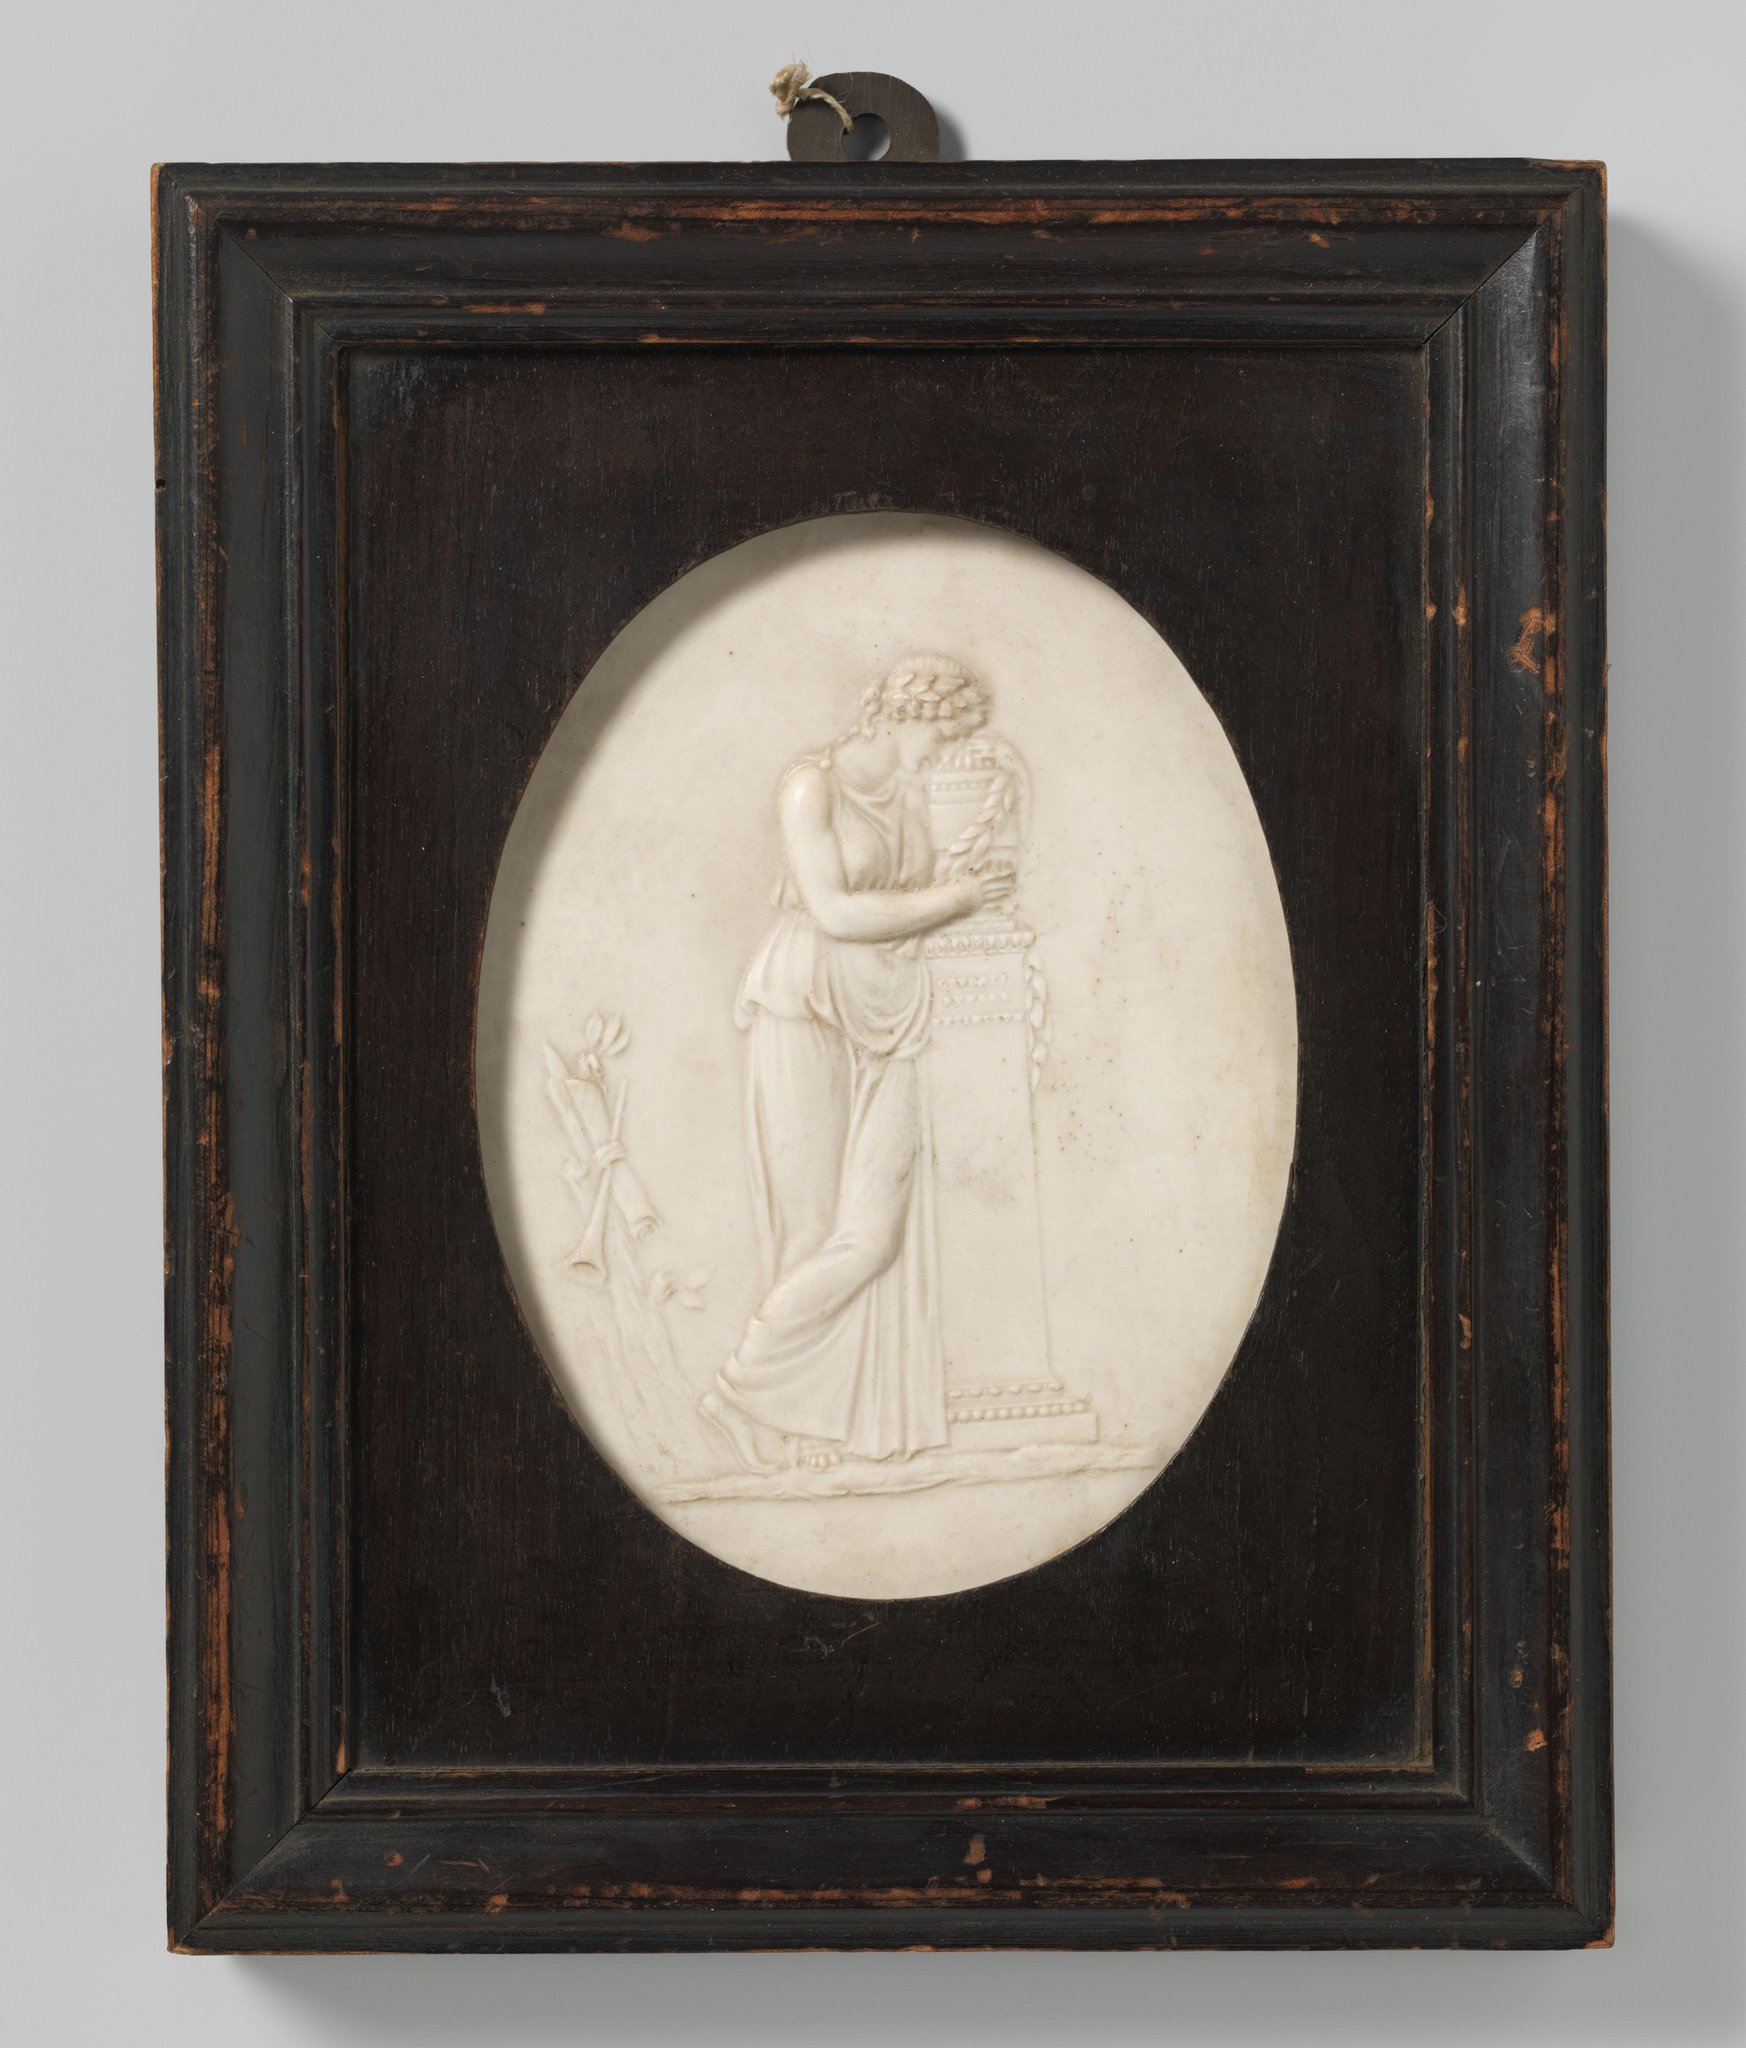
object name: locket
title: Treurende vrouw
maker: Anonymous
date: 1775-1800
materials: marble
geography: netherlands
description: Medaillon van marmer waarop in reliëf een in lang gewaad geklede vrouw staat, treurend geleund tegen een grafmonument.